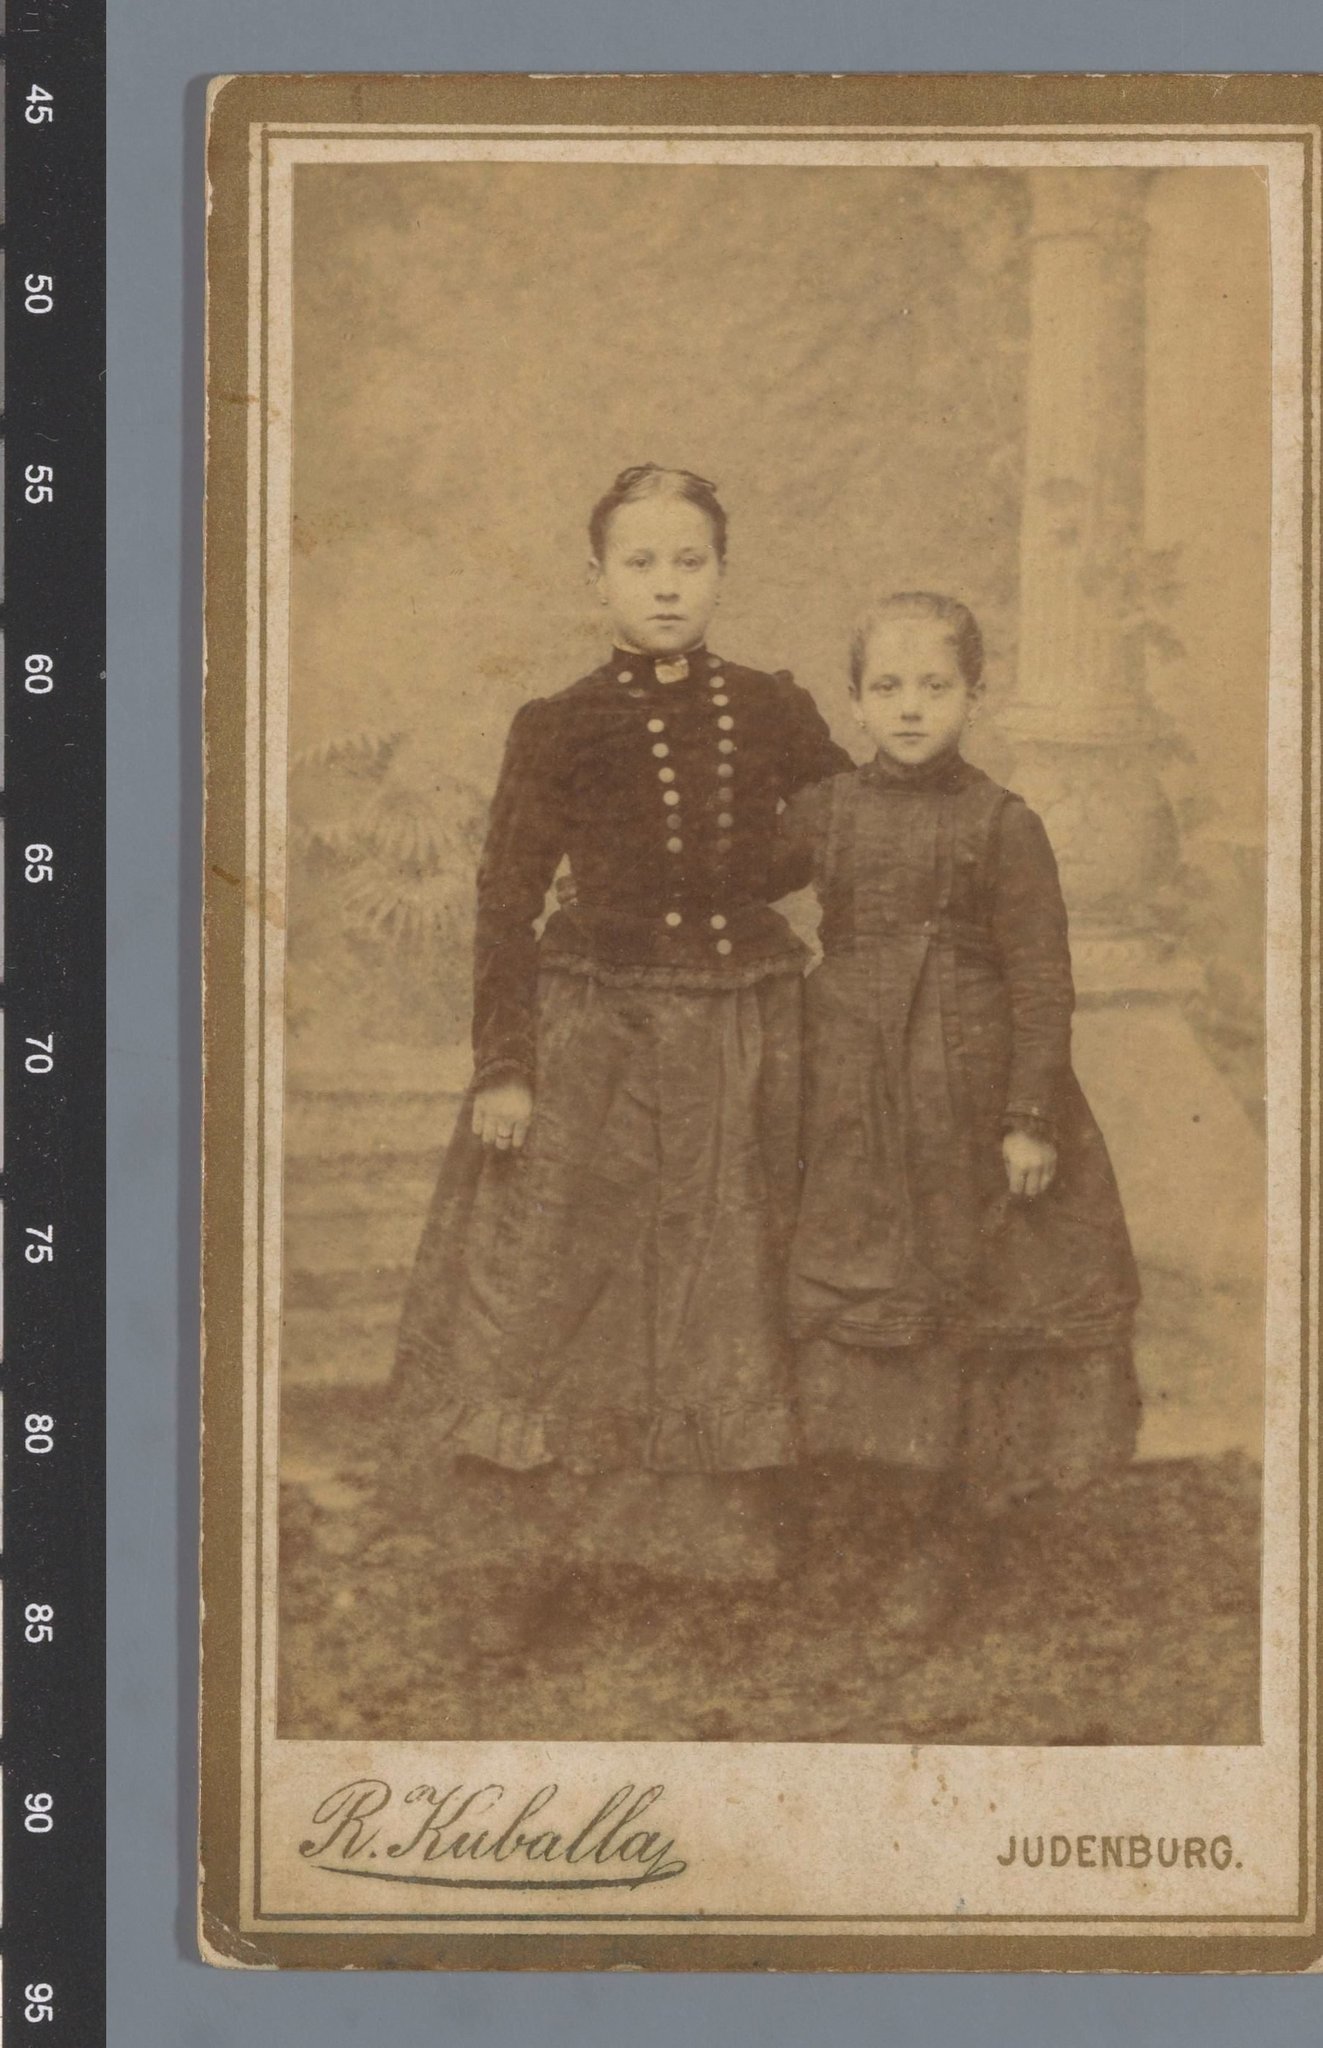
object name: carte de visite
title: Portret van twee onbekende meisjes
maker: r. kuballa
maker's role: fotograaf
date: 1850-1900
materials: cardboard, photographic support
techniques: albumen print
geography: judenburg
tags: historical persons not known by name - bb - woman, girl (child between toddler and youth)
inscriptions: address: ‘Photogr. Artist./ ATELIER/ von/ R. Kuballa/ JUDENBURG/ Herrengasse 2./ rückwärts im Garten./ Es können selbst nach Jahren Nachbestellungen/ gemacht werden, da die Originalplatte aufbewahrt/ wird./ A. M. Wrabetz, Wien’, annotation: ‘F’